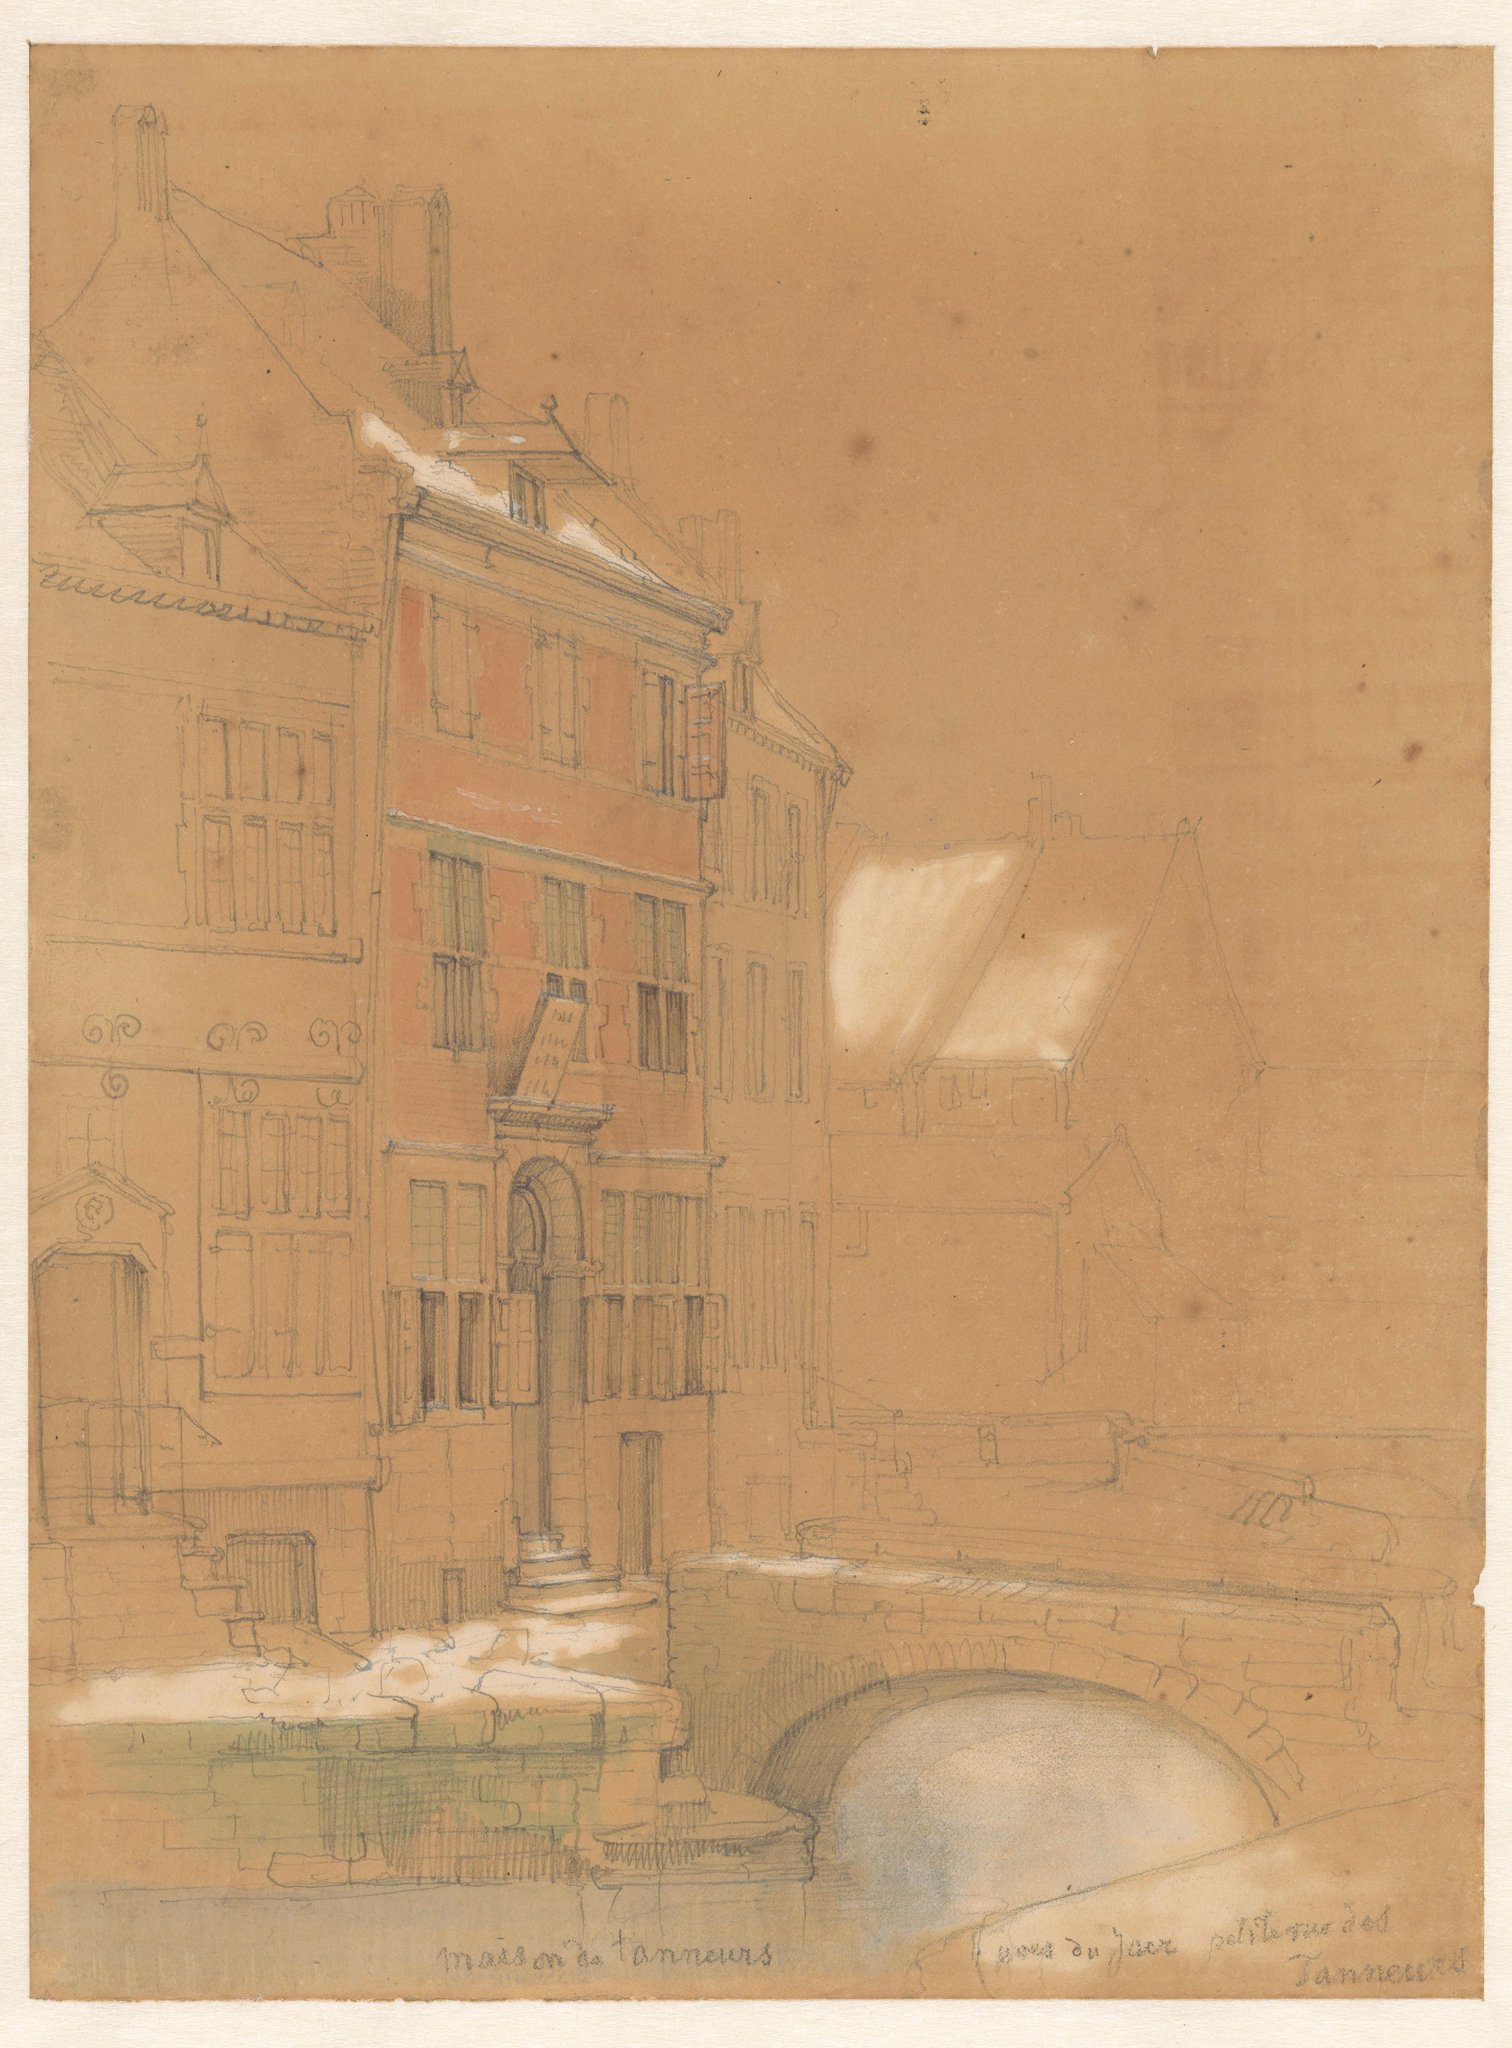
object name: watercolor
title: Huis van leerlooiers te Maastricht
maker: alexander schaepkens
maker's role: draughtsman, print maker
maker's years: 1815-1899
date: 1839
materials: paper, pencil, watercolor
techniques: brush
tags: street, maastricht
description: Het huis der leerlooiers te Maastricht, gelegen aan de Kleine Looiersstraat.